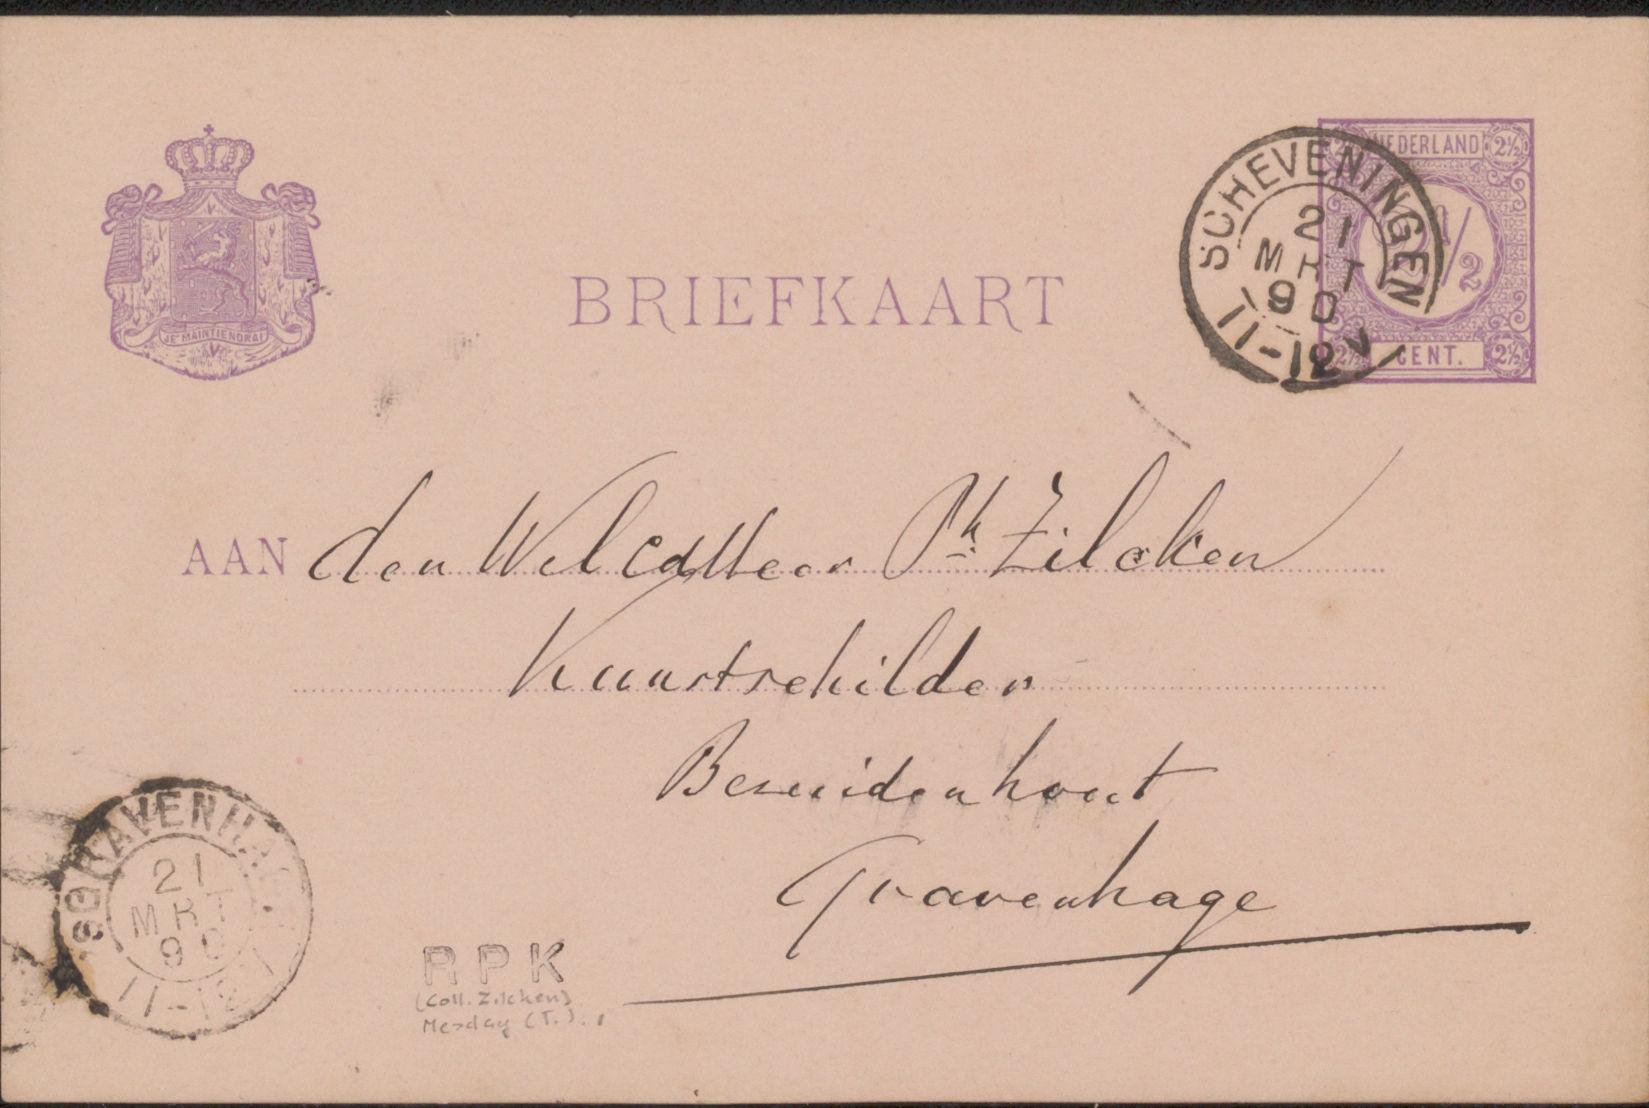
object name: postcard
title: Briefkaart aan Philip Zilcken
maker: taco mesdag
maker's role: draughtsman, painter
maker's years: 1829-1902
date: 1890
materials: cardboard, ink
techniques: pen, writing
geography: scheveningen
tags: the hague, painter, philip zilcken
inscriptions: collector's mark: ‘RPK’